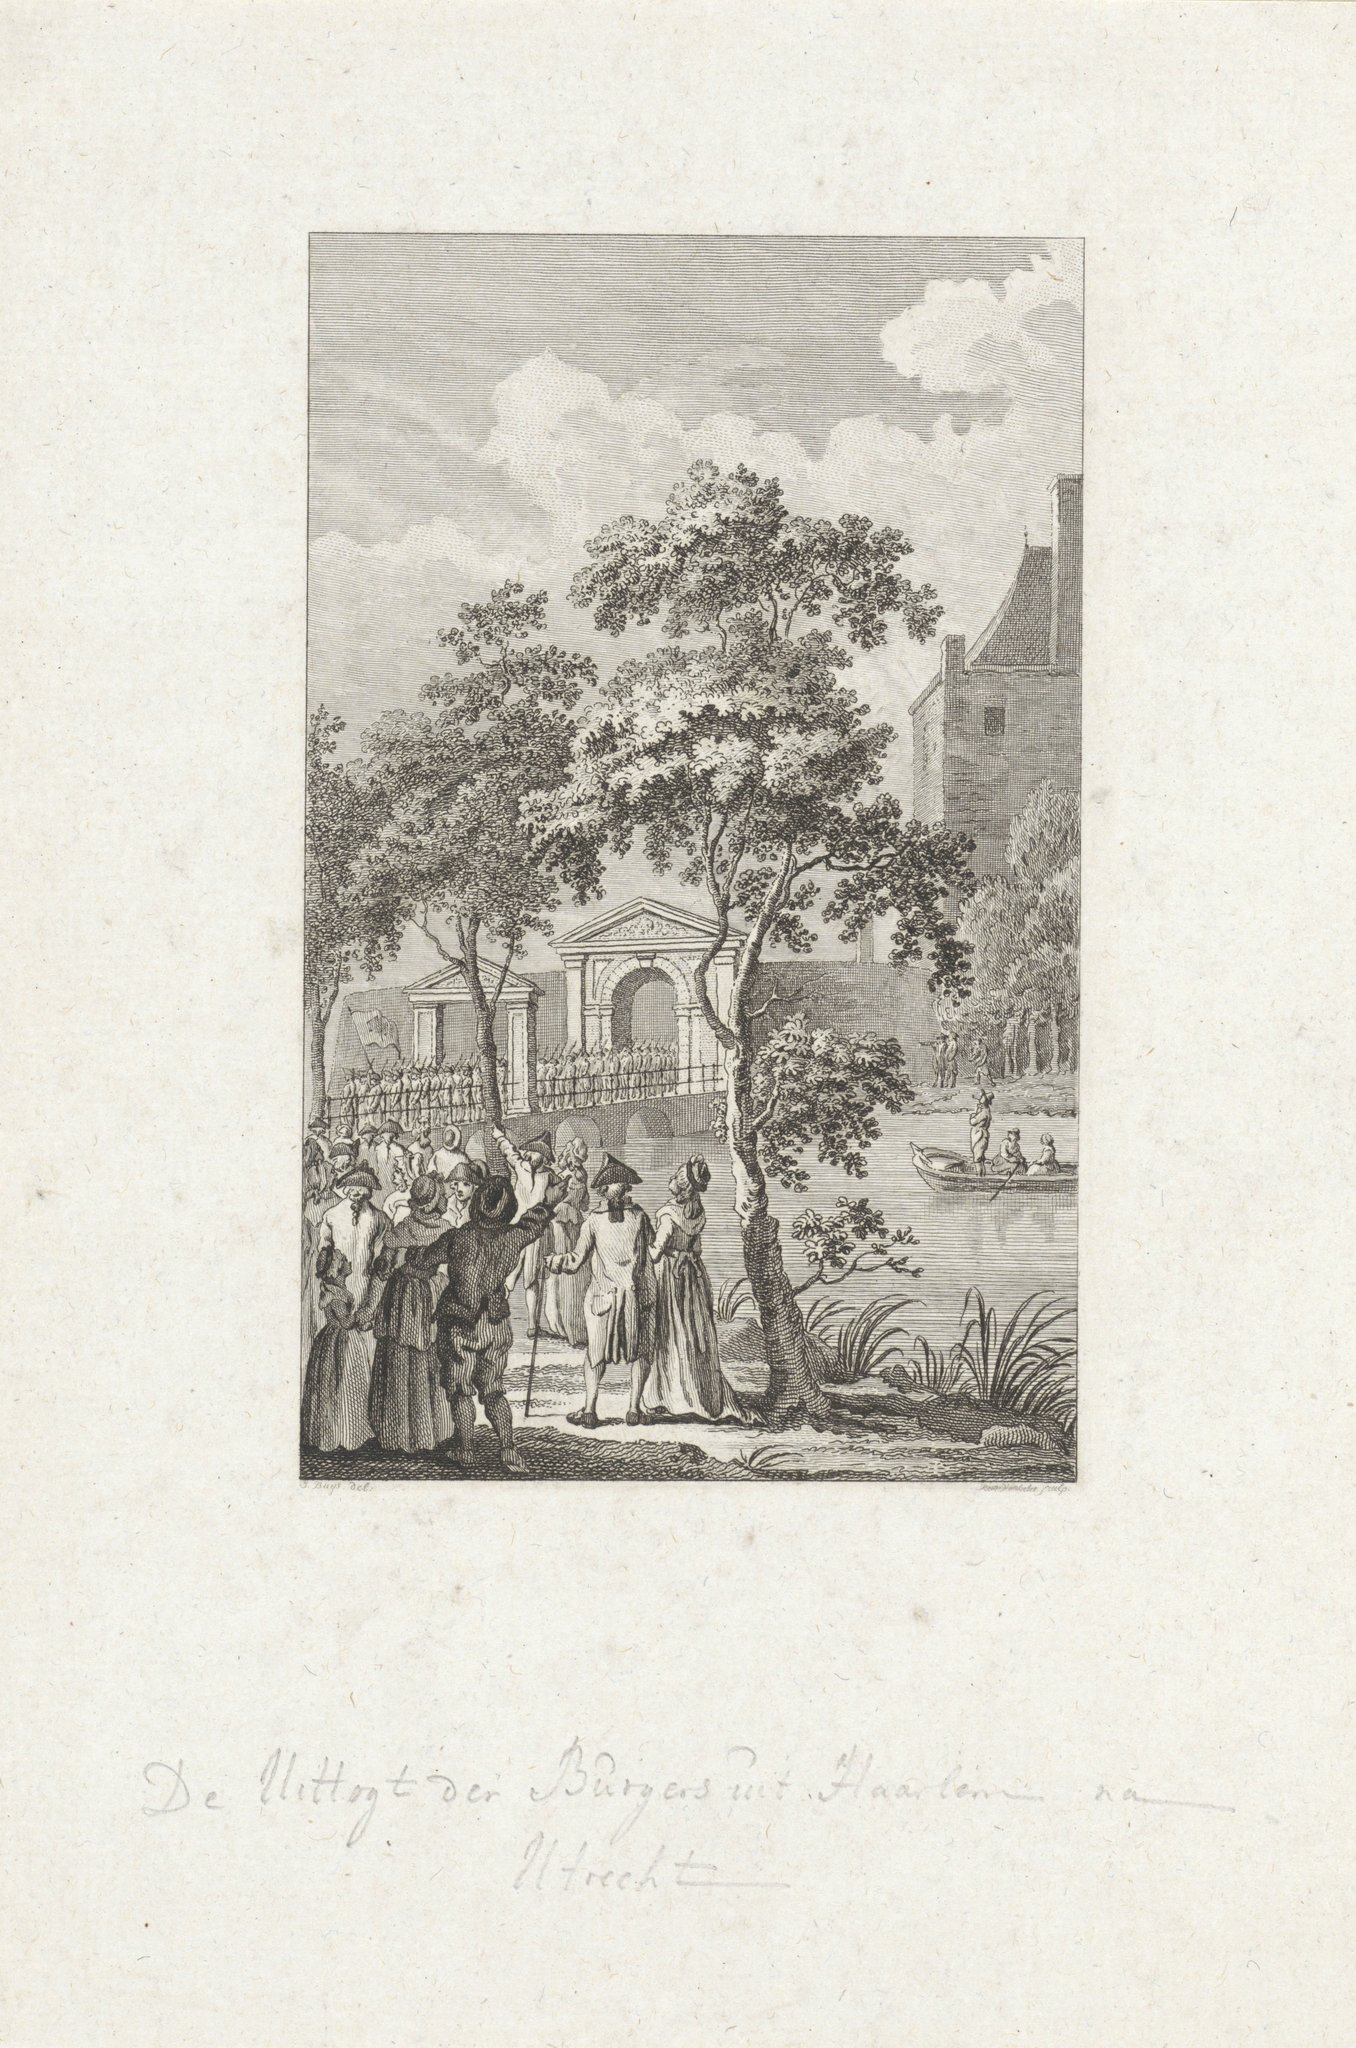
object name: history print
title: Haarlemse burgers trekken op naar Utrecht, 1786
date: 1794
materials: paper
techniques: engraving, etching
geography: amsterdam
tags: troop movements, transportation (+ citizen soldiery, civil guard, citizen militia), haarlem, patriots (1780-1795)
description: Gebruikt als illustratie in: P.A. Loosjes, Vaderlandsche historie, vervattende de geschiedenissen, der Vereenigde Nederlanden (...). Ten onmiddelyken vervolge van Wagenaar's Vaderlandsche historie, dl. 12.